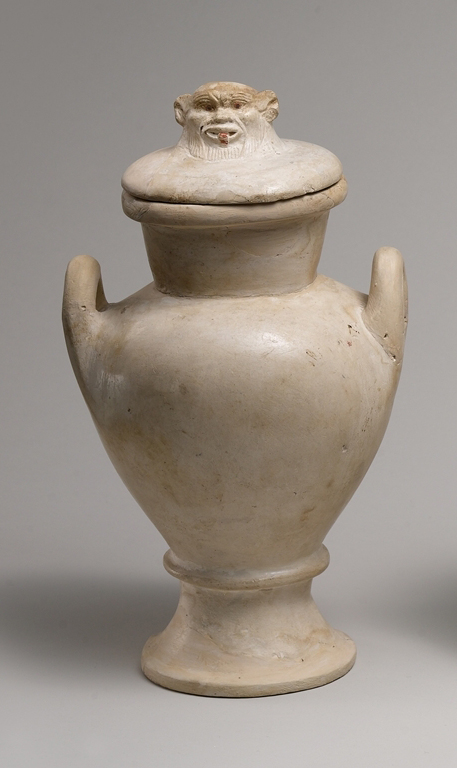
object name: jar and lid, be head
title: Two Handled Jar and Lid with the Head of Bes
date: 1390-1352 BCE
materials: limestone, paint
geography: egypt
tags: bes